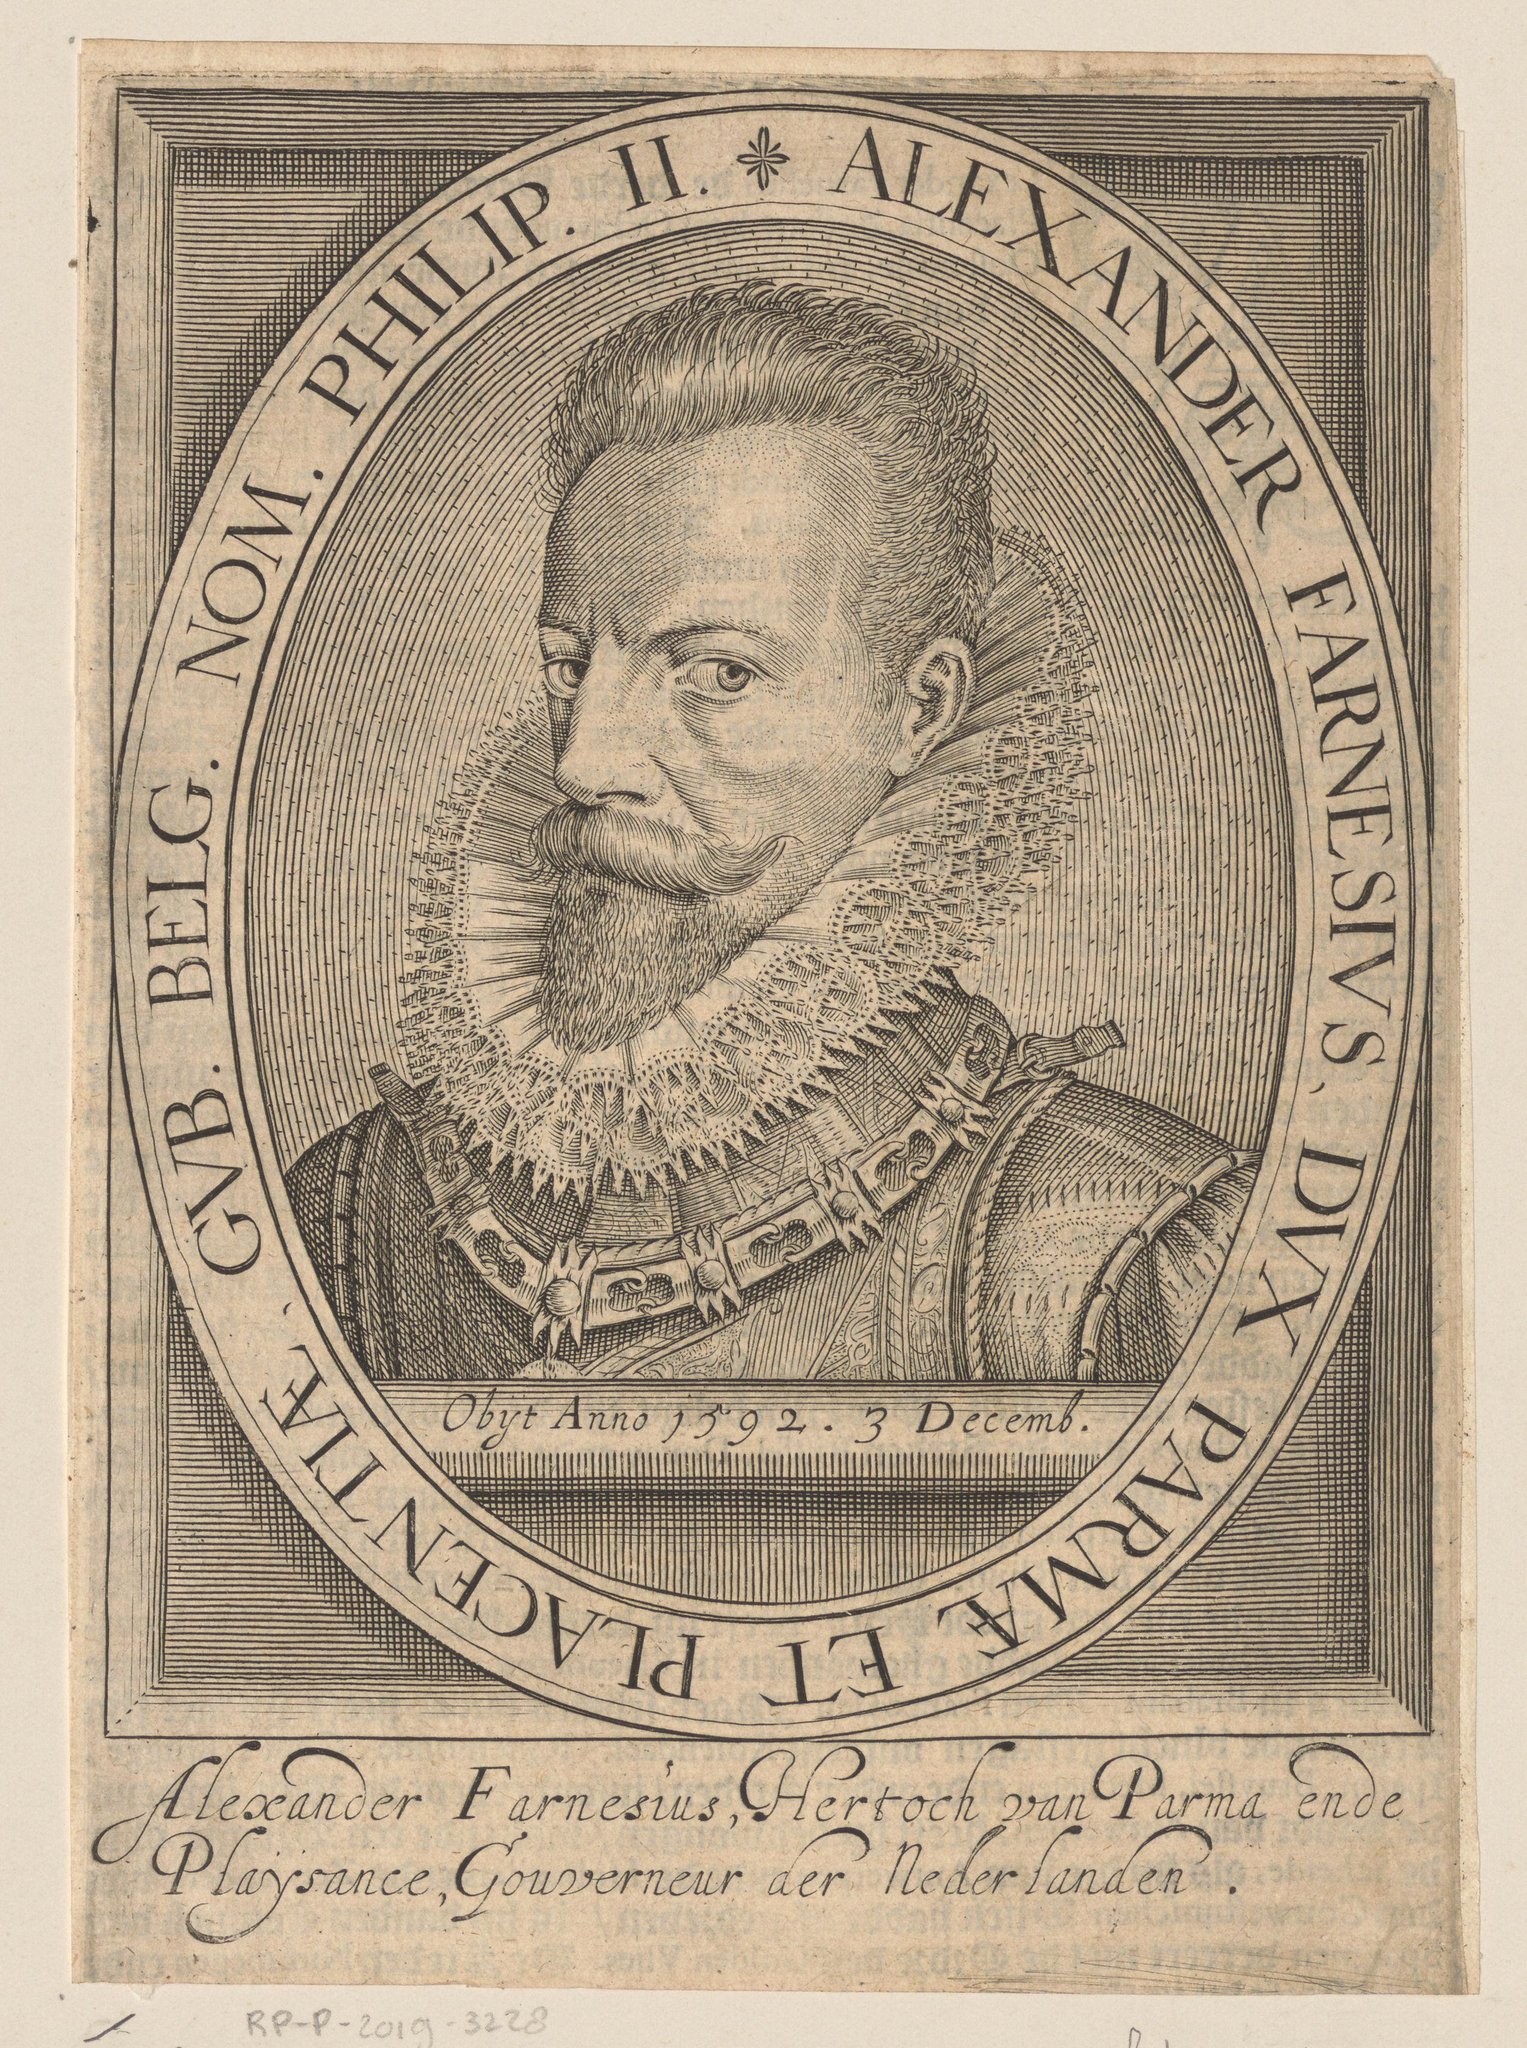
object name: book illustration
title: Portret van Alexander Farnese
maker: Anonymous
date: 1610-1640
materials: paper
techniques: engraving, etching, letterpress printing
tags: rome, alessandro farnese (landvoogd van de nederlanden en hertog van parma en piacenza), historical persons, knighthood order of the golden fleece - insignia of a knighthood order, e.g.: badge, chain (with name of order)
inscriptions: (false)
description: Met om zijn nek de keten van de Orde van het Gulden Vlies.